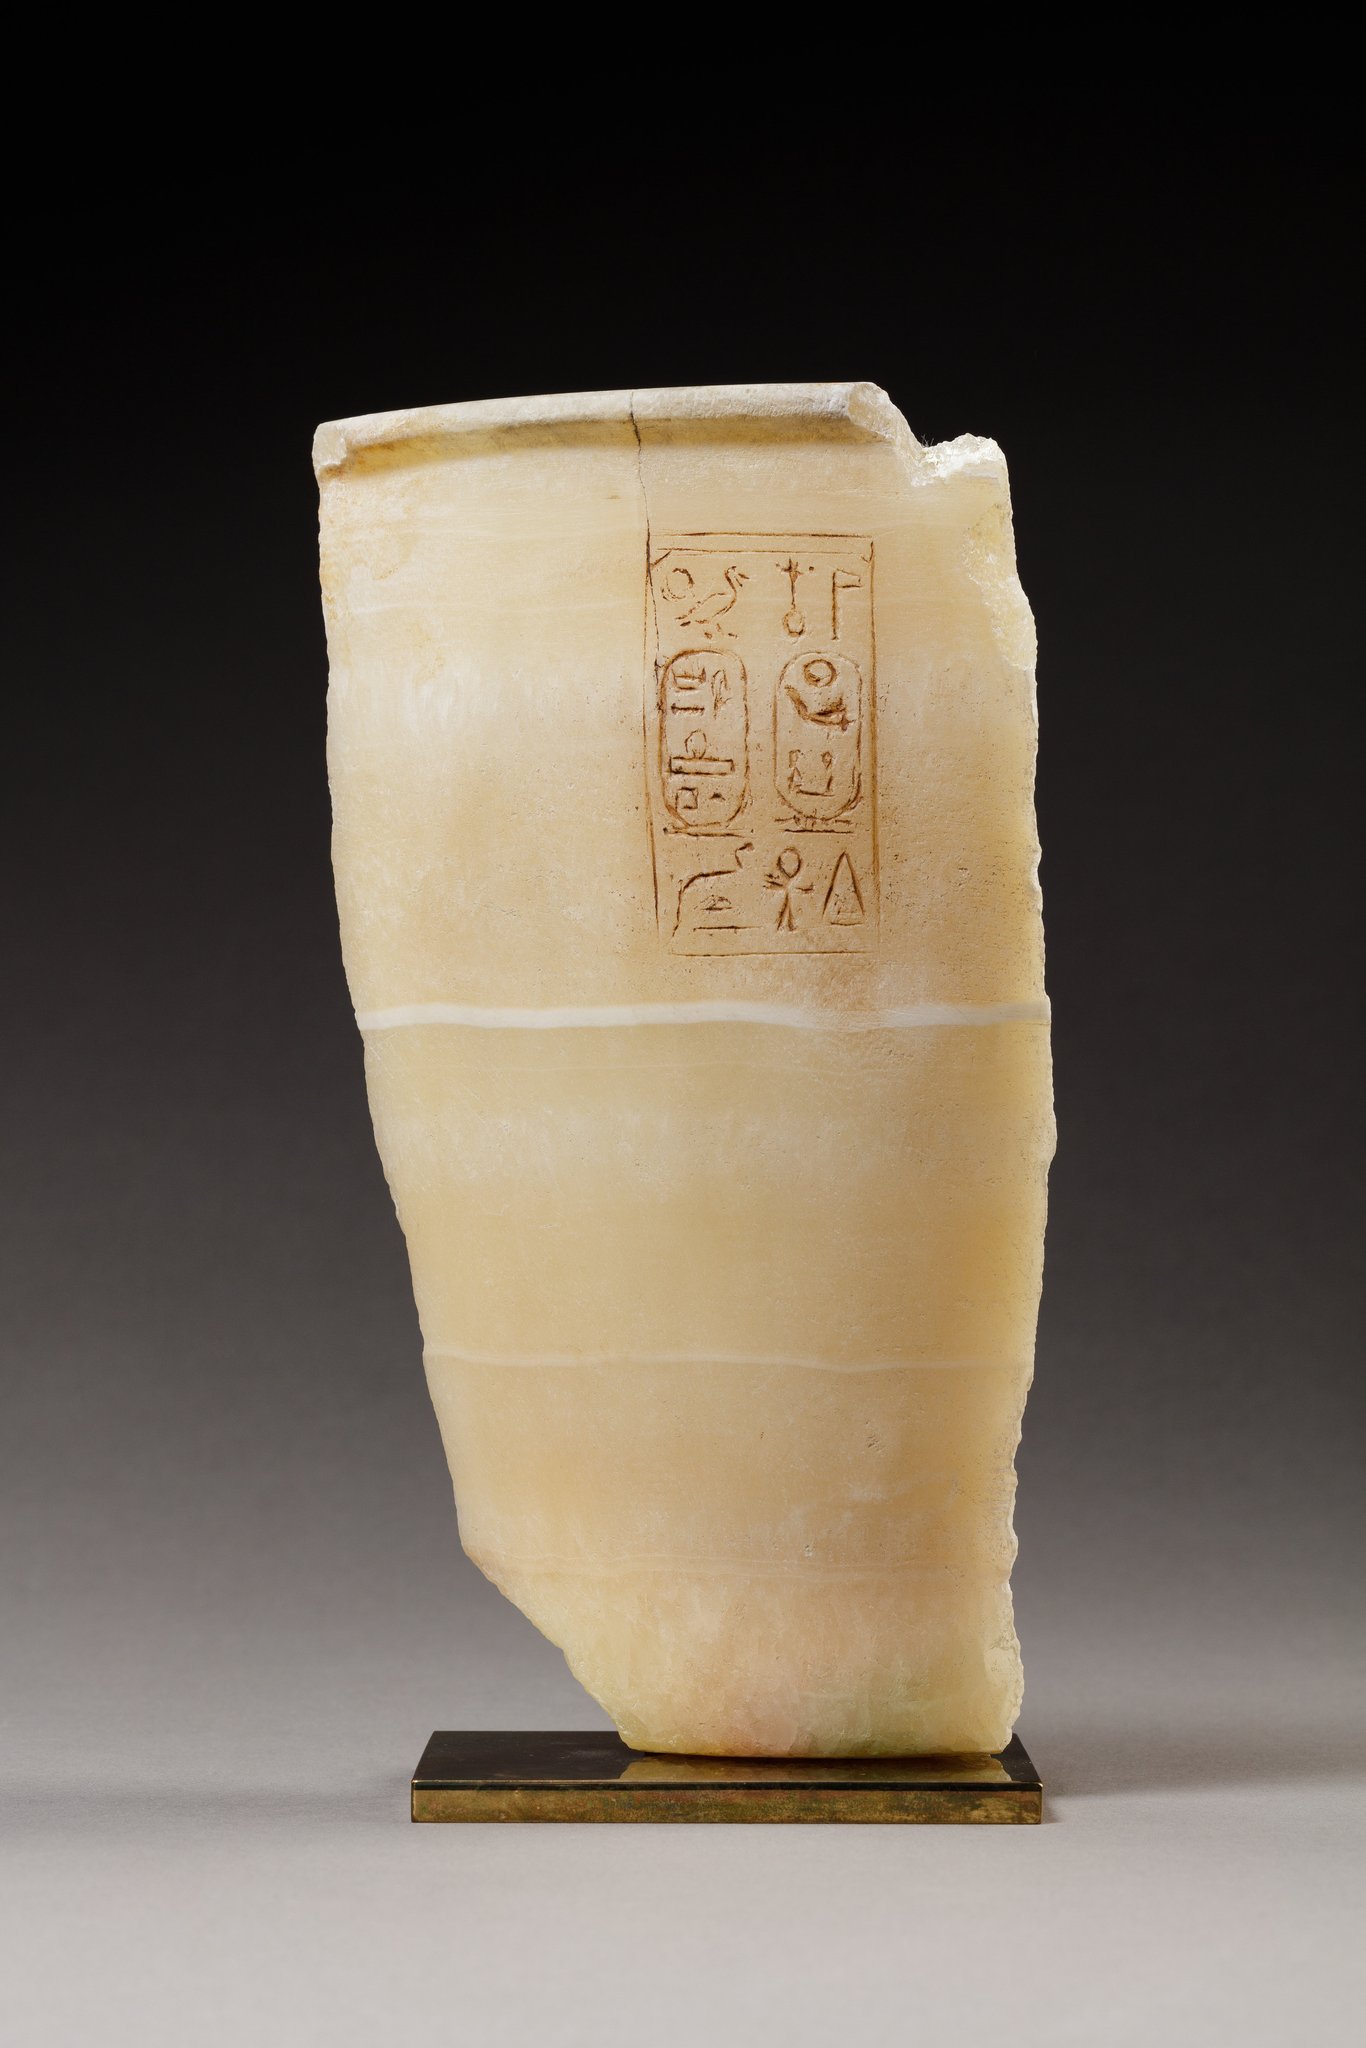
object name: jar, amenhotep i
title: Jar of Amenhotep I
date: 1525-1504 BCE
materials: stone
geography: egypt